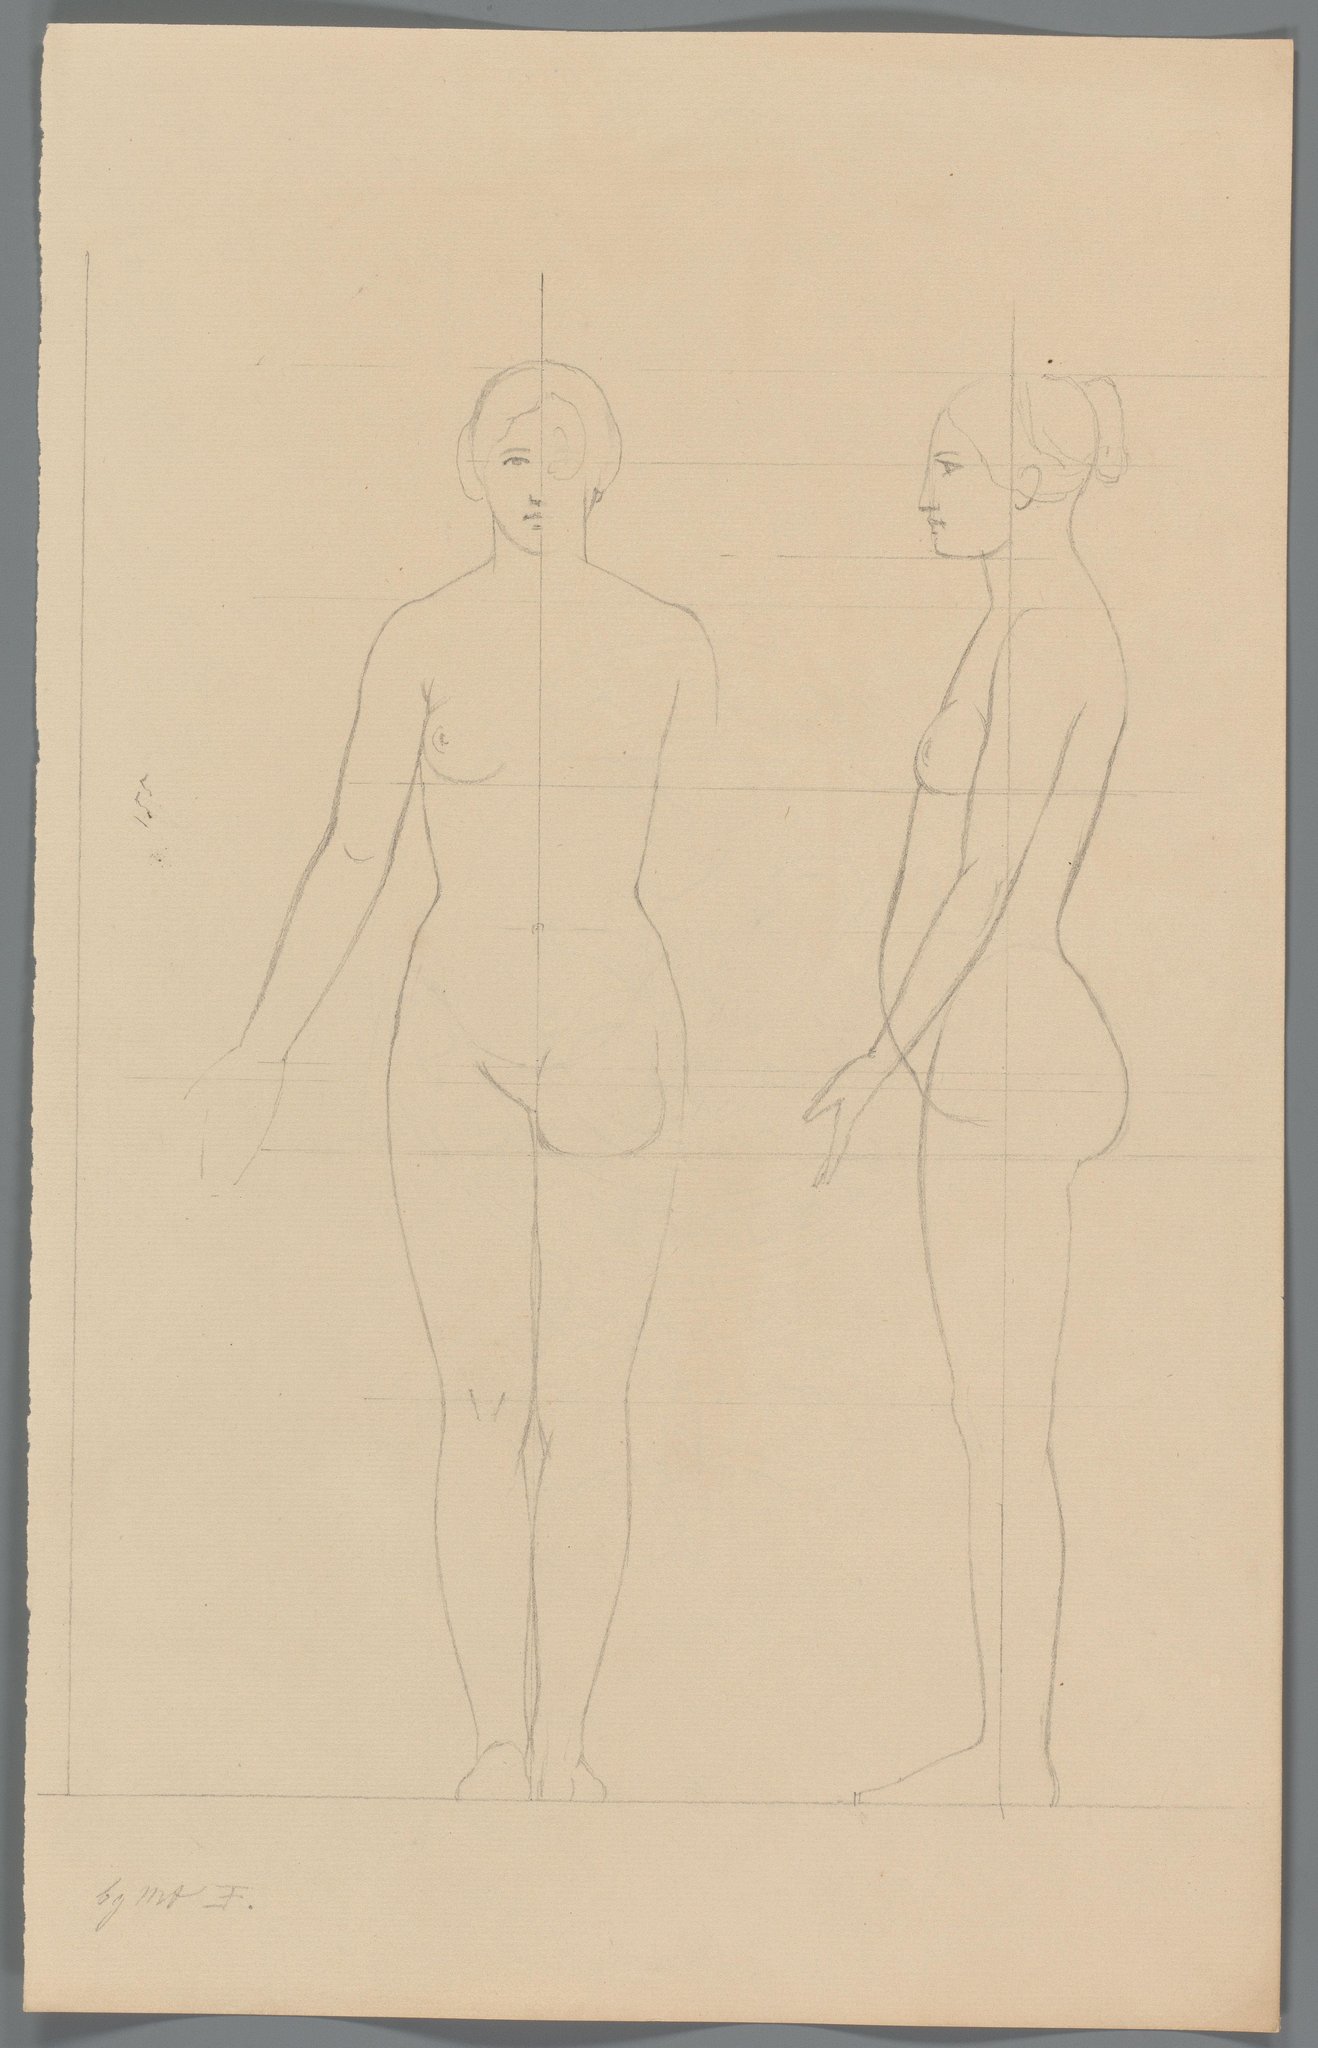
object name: drawing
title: Proportiestudie van een vrouw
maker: jacobus everhardus josephus van den berg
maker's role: draughtsman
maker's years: 1802-1861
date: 1856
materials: paper, pencil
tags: standing figure (canon, proportions) - aa - female human figure, anatomy (non-medical) - aa - female human figure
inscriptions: inscription: ‘hg mt EF’